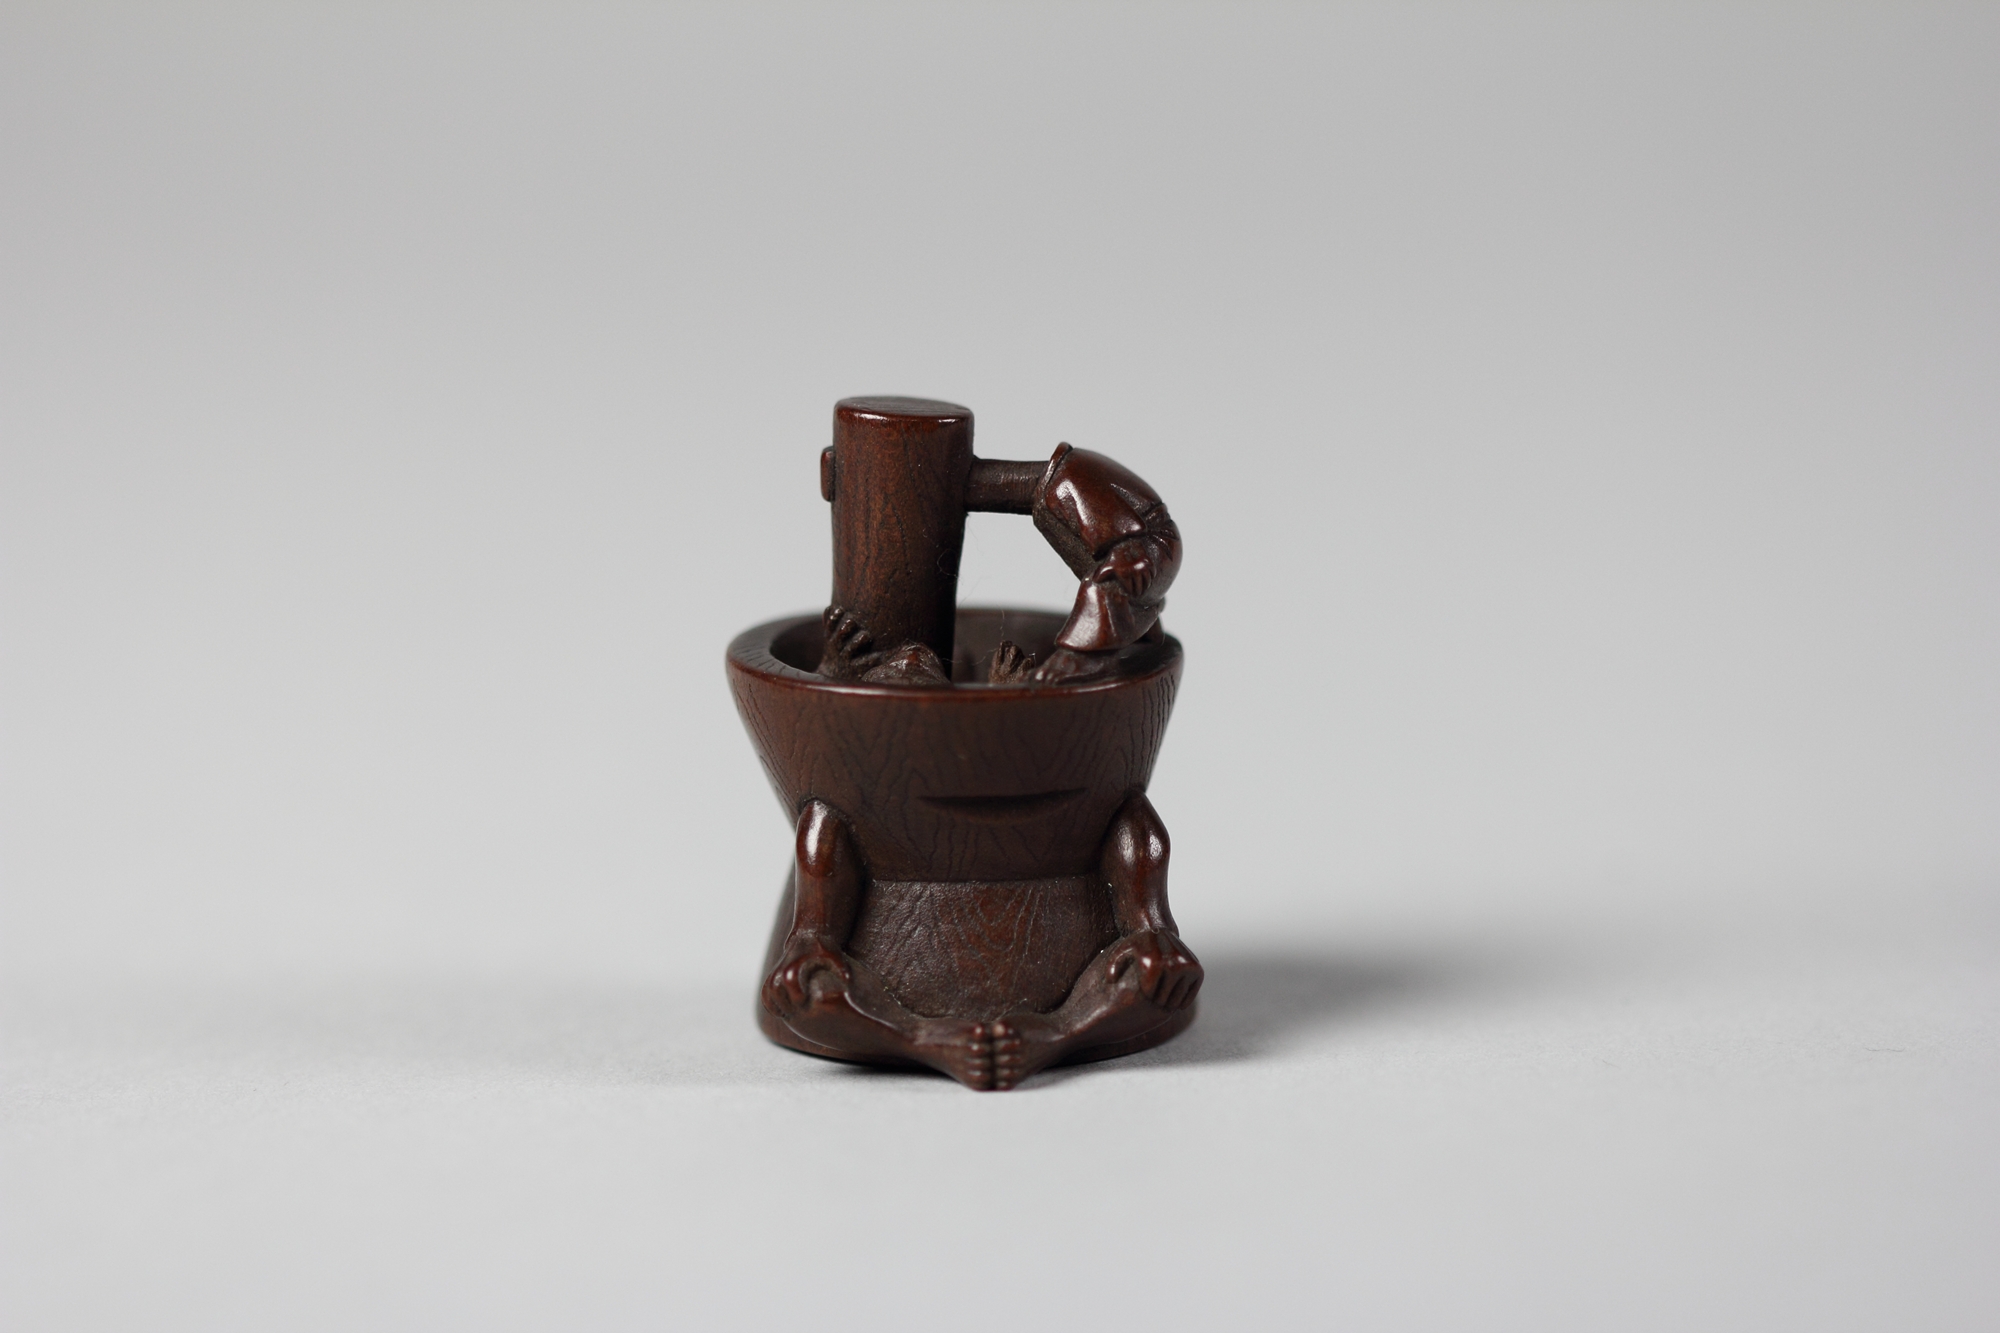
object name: netsuke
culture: japanese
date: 1801-1900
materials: wood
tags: human figures